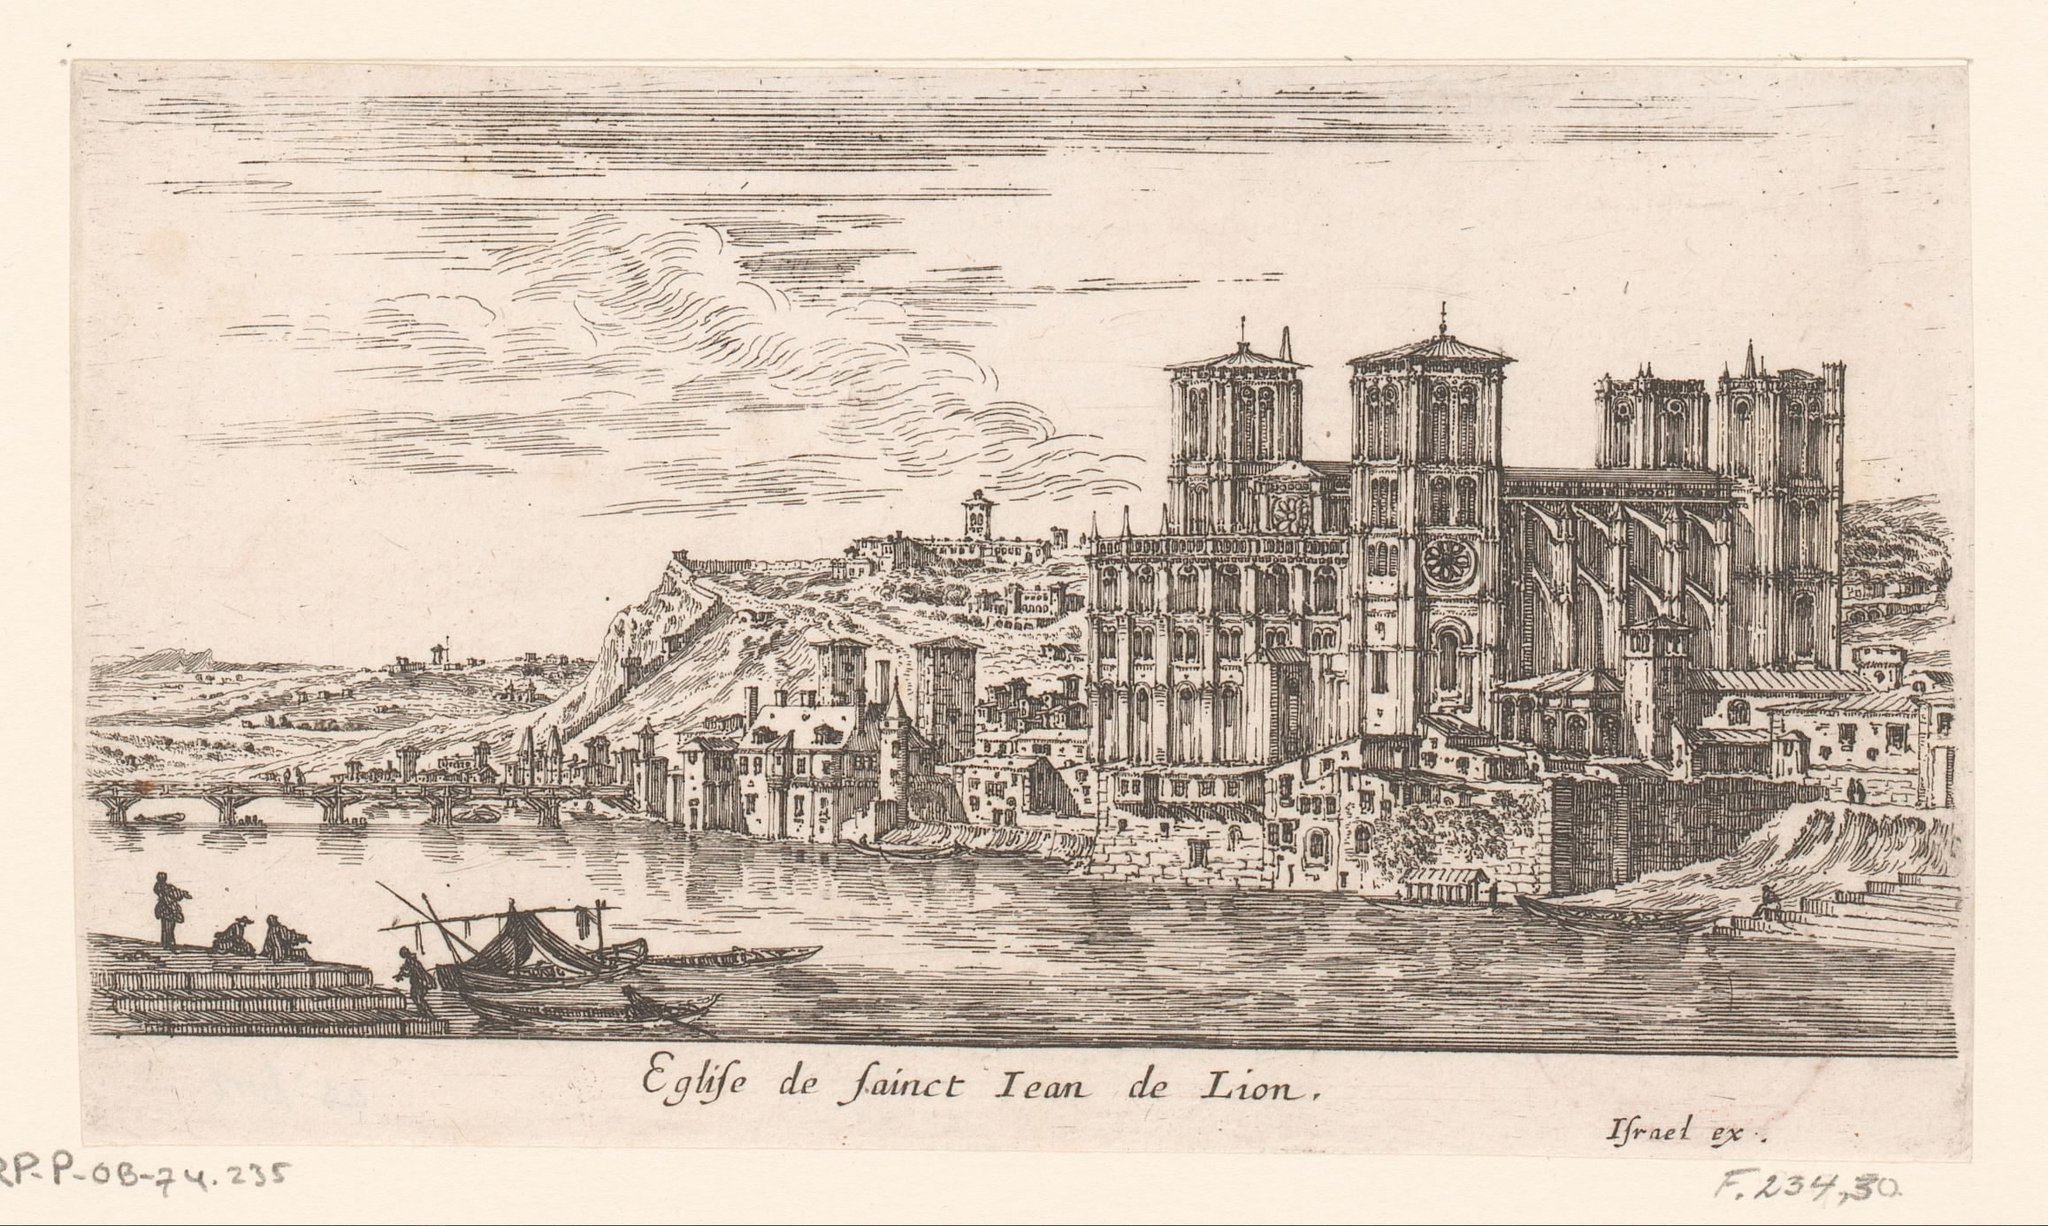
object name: print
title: Eglise de sainct Jean de Lion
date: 1631-1691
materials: paper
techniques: engraving, etching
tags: city-view, and landscape with man-made constructions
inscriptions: collector's mark: Lugt 240